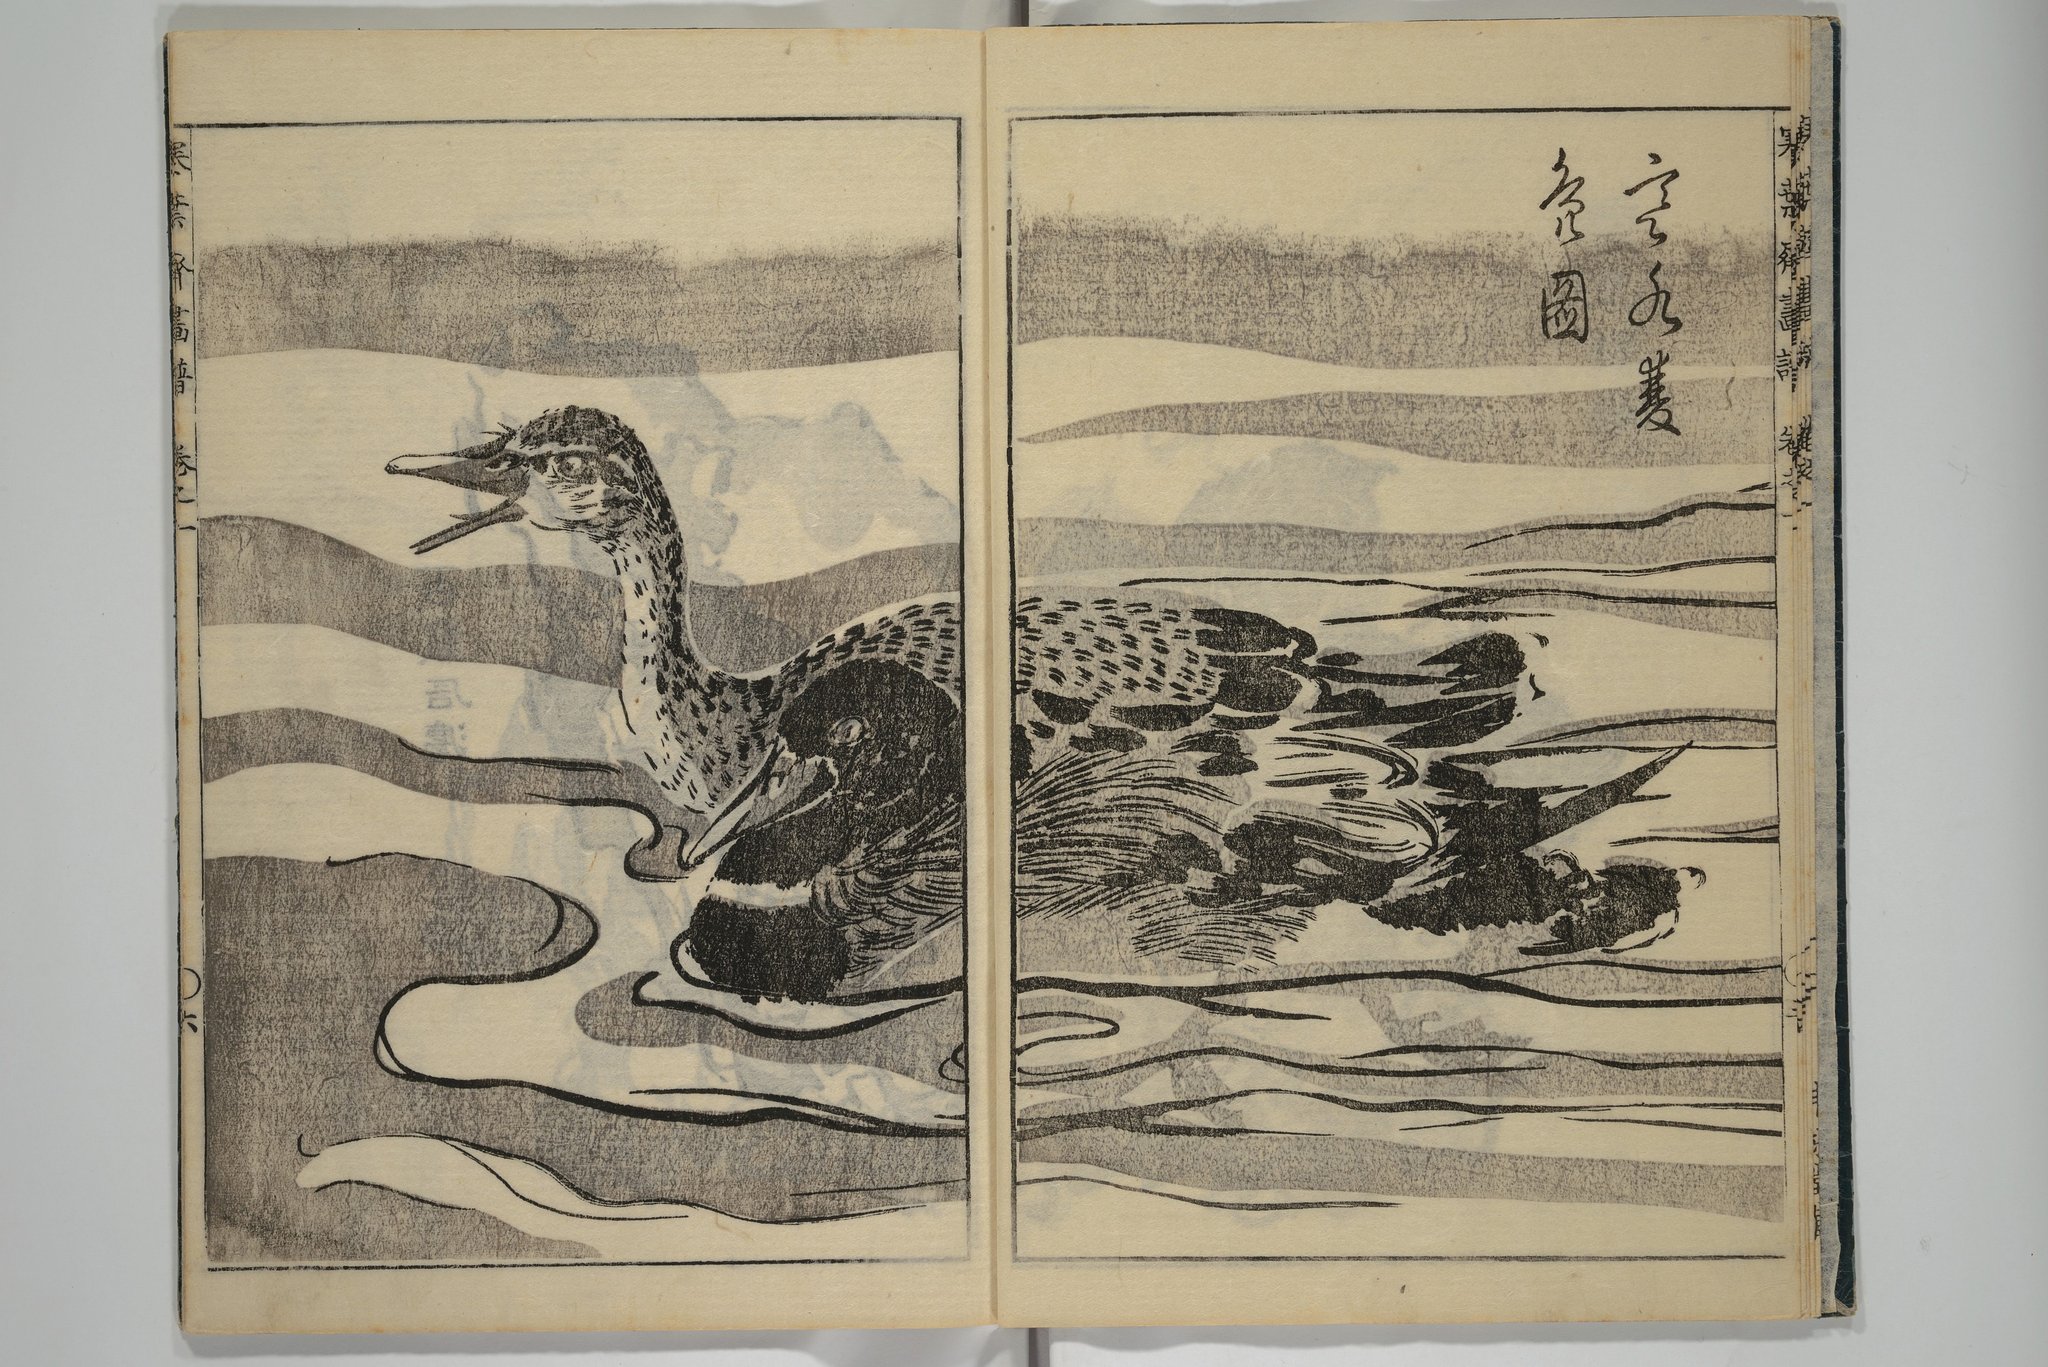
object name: illustrated book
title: Kan'yōsai Picture Album (Kan'yōsai gafu) 寒葉斎画譜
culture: japanese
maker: kan'yōsai 寒葉斎 (tatebe ayatari 建部綾足)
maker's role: artist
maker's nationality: japanese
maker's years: 1719-1774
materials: ink, paper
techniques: woodblock print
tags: ducks